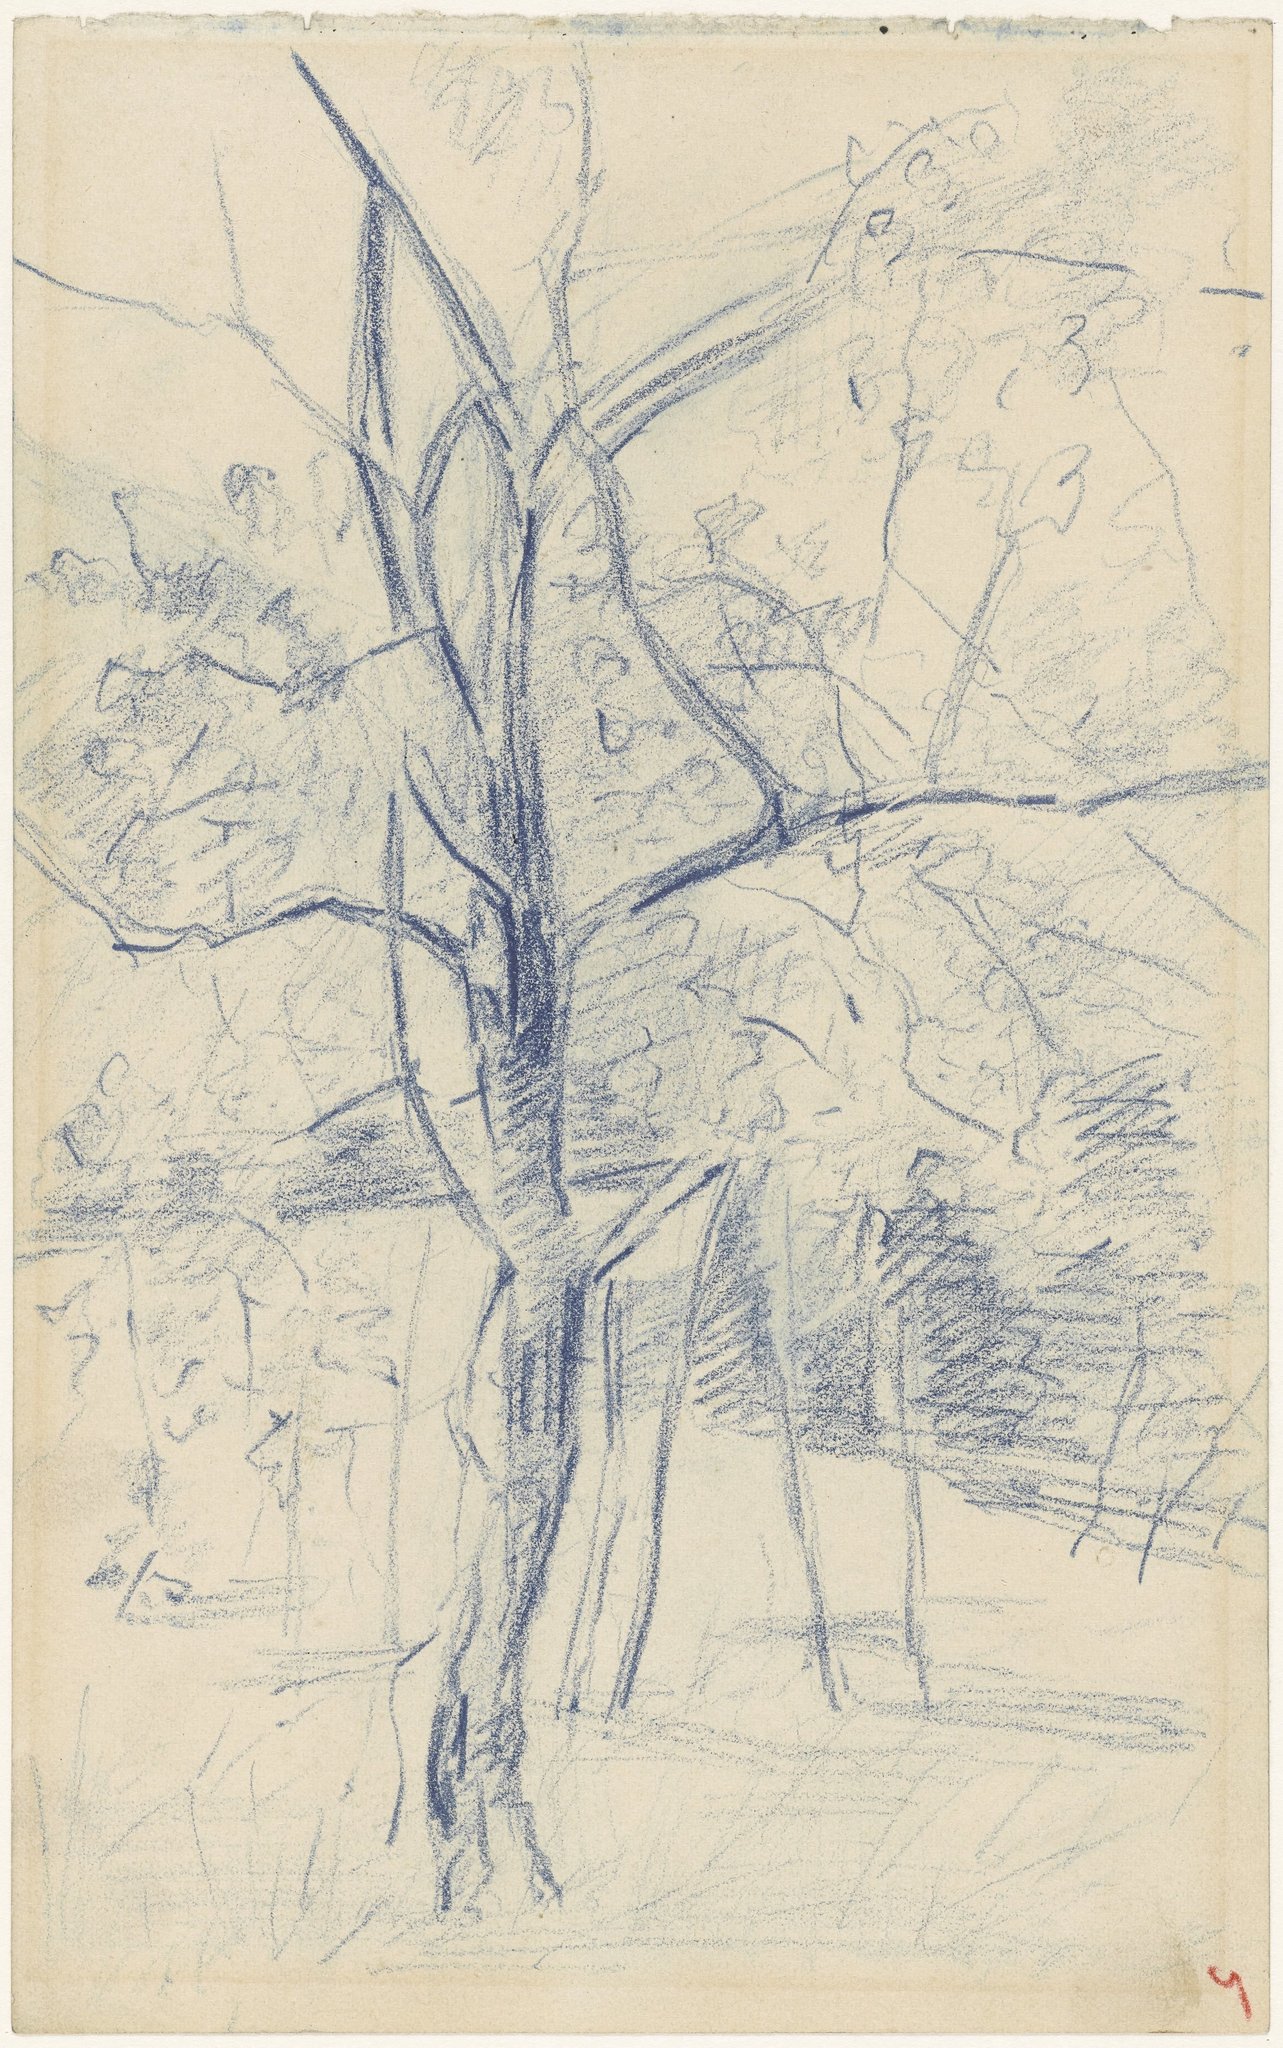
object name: drawing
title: Boompje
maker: jozef israëls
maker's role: draughtsman, painter, print maker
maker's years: 1824-1911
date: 1834-1911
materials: chalk, paper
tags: trees